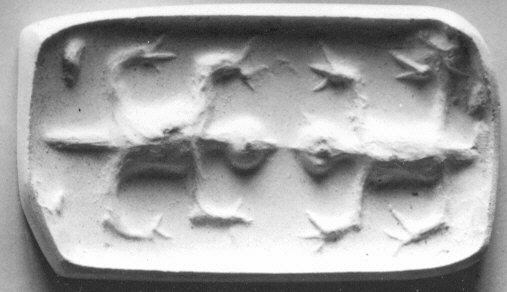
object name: stamp seal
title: Gable seal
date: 3500-2900 BCE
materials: marble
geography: mesopotamia